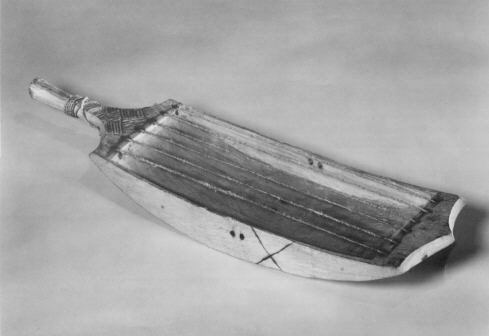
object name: trough zither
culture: malawian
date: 1867-1900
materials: hemp, wood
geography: malawi